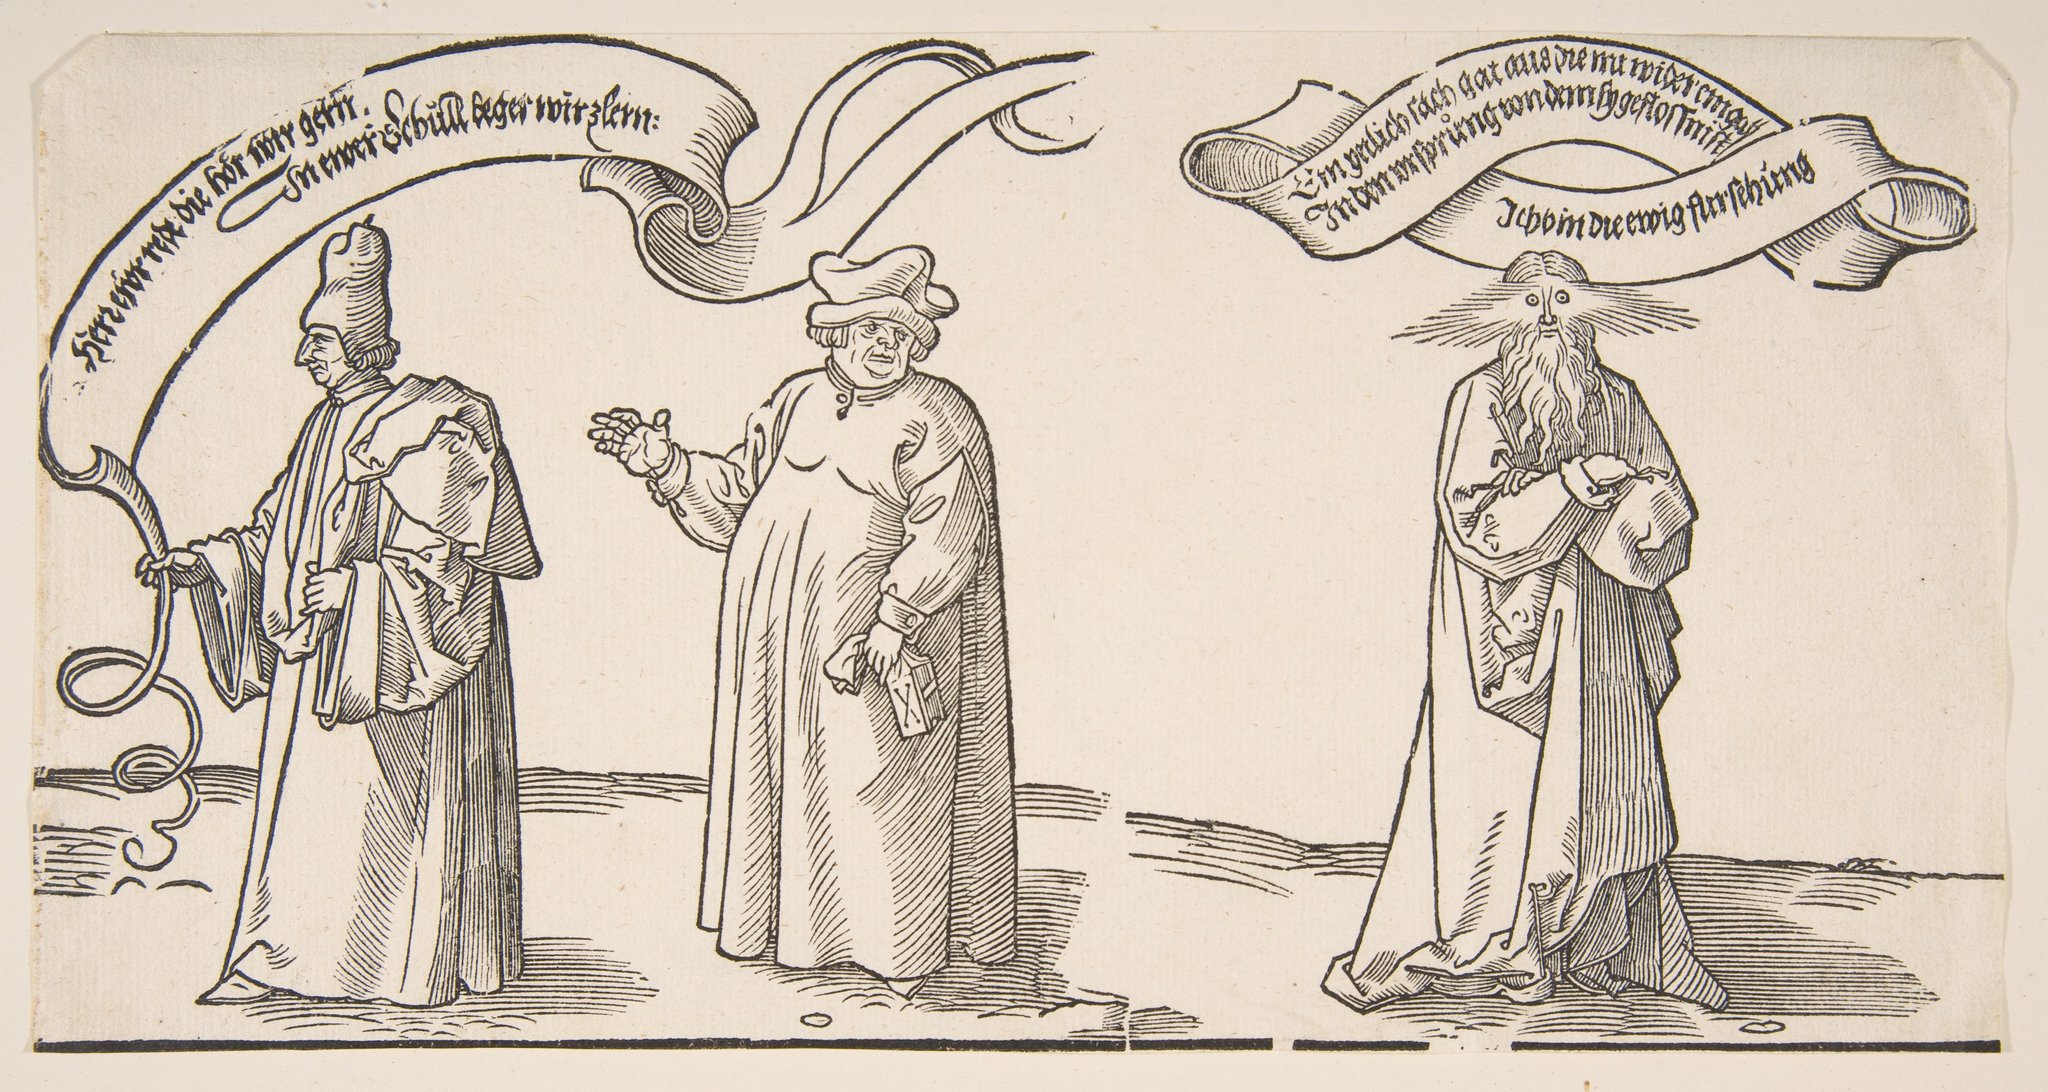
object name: print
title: The Tapestry at Michelfeld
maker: albrecht dürer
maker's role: artist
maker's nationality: german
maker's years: 1471-1528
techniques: woodcut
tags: men,women